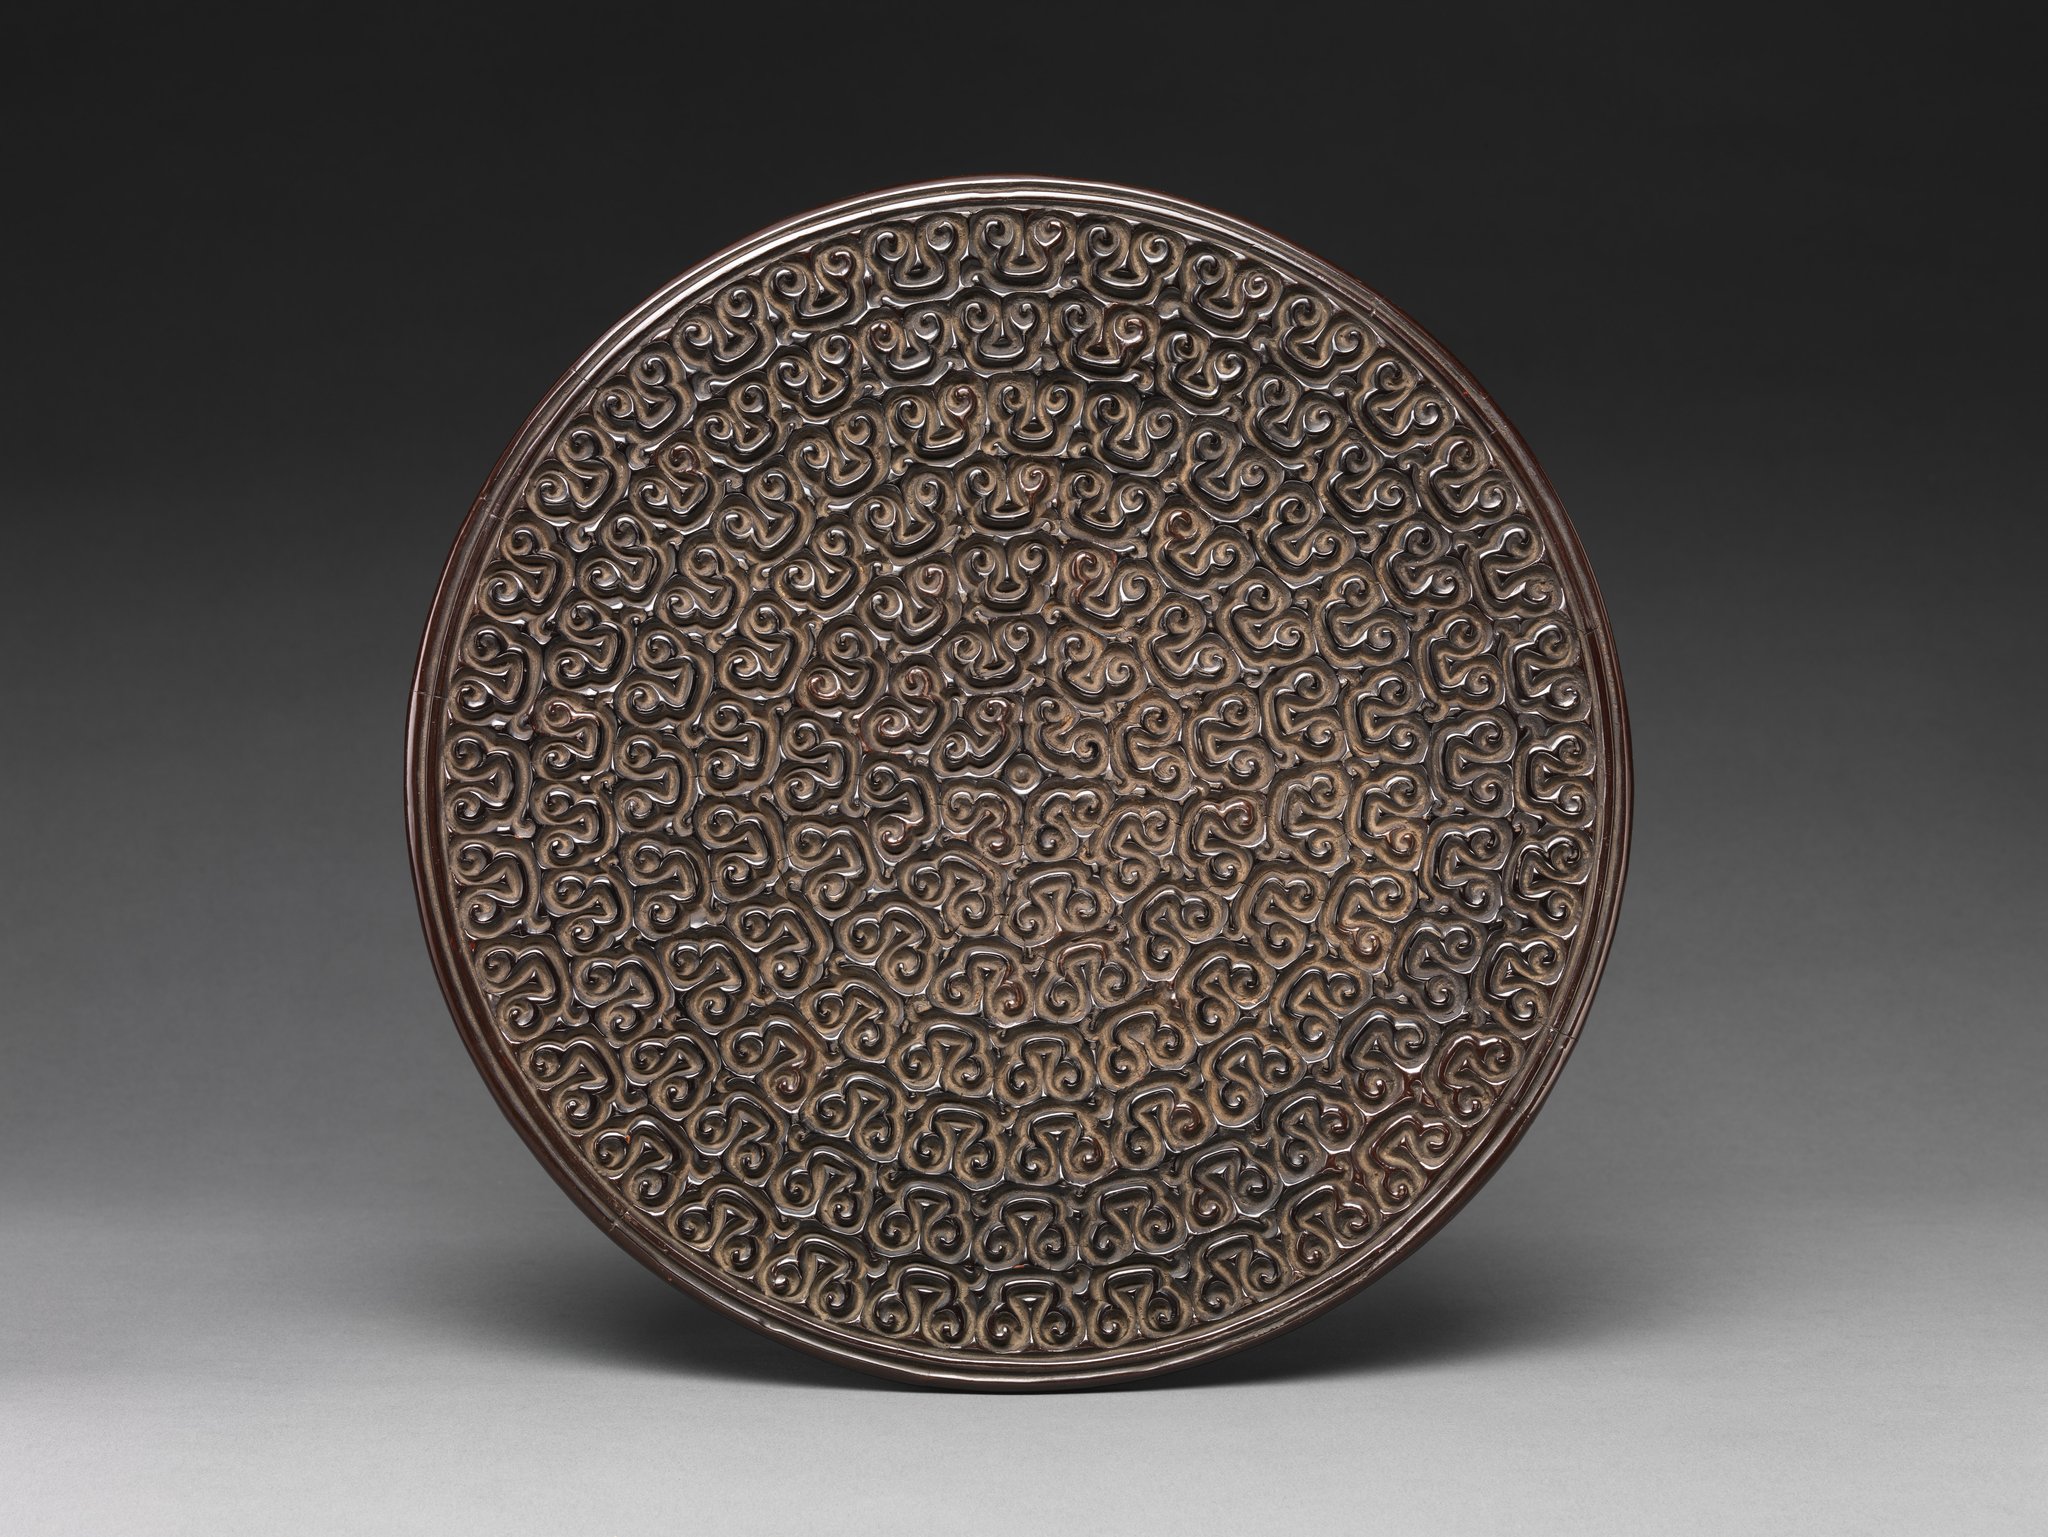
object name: plaque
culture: chinese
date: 1201-1333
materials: lacquer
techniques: carving